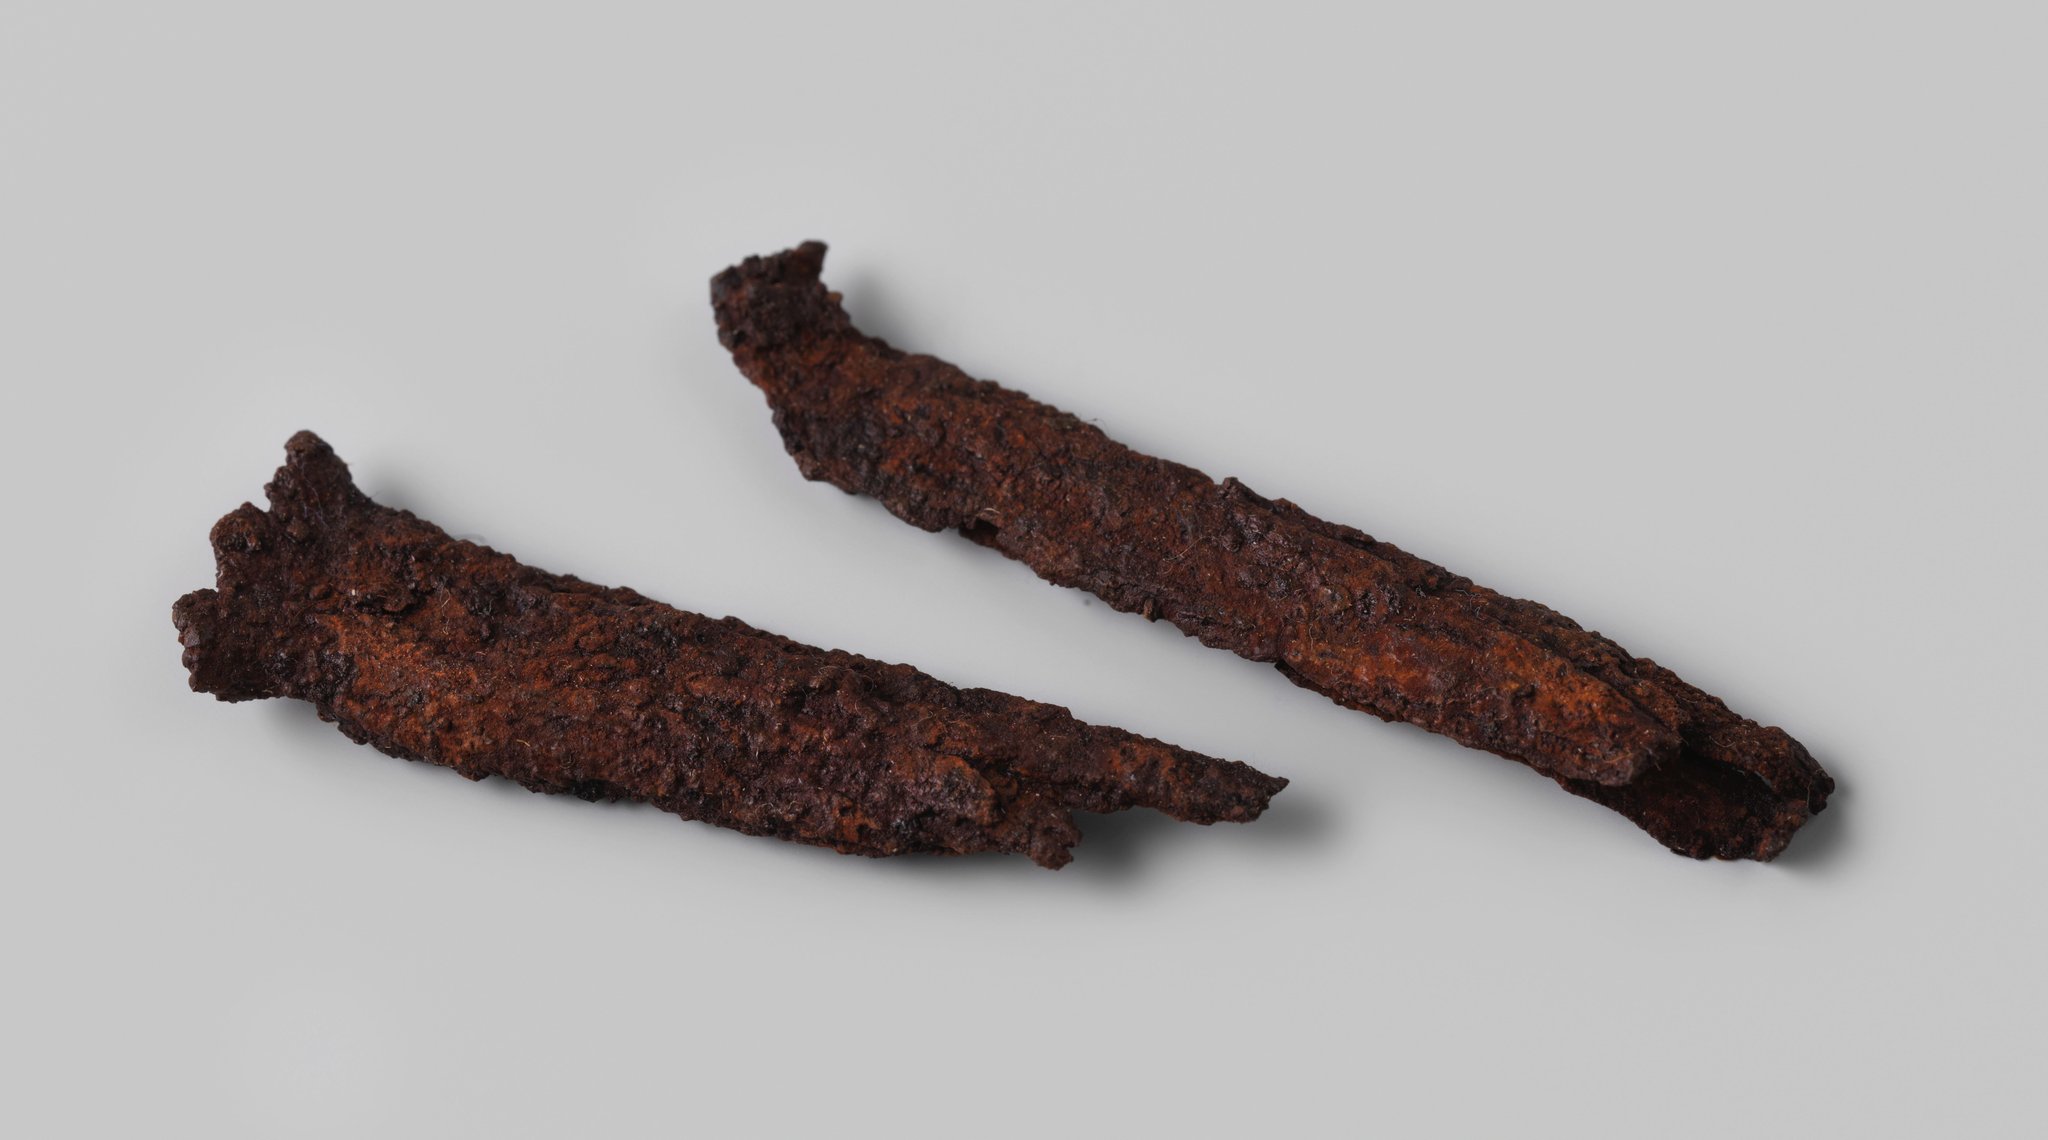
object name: strip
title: Fragment van ijzeren stroken uit het wrak van de Oost-Indiëvaarder Hollandia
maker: Anonymous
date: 1700-1743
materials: iron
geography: netherlands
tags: verenigde oostindische compagnie, hollandia (schip), annet